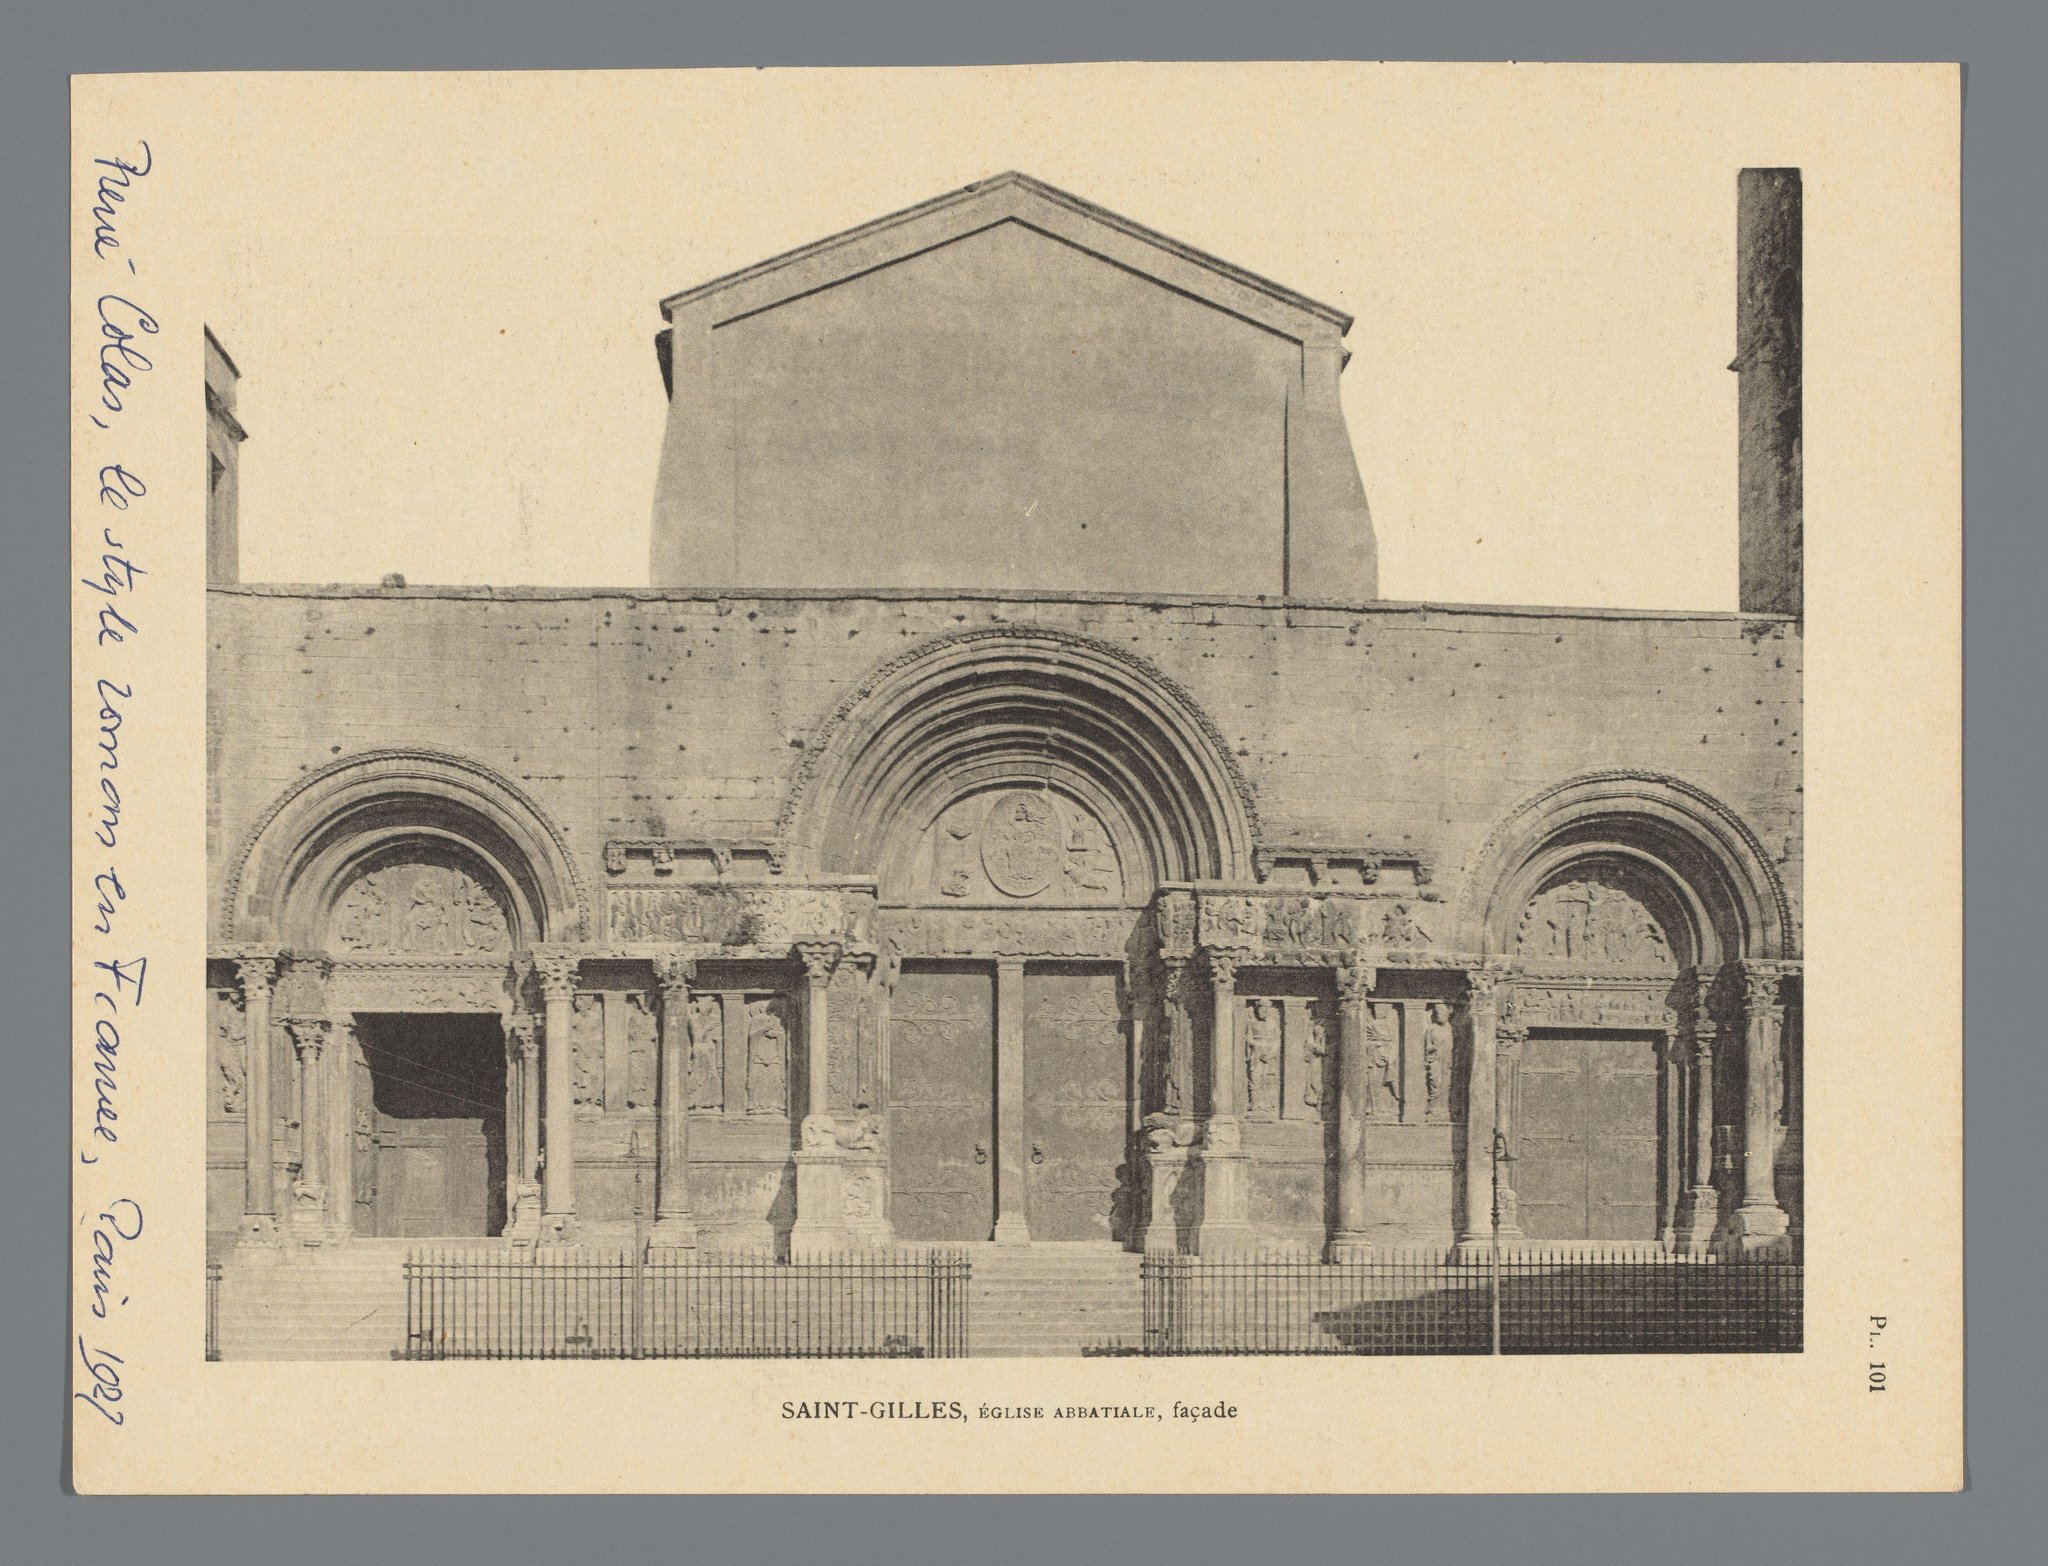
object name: photograph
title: Saint-Gilles, Kirche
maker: Anonymous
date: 1900-1950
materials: paper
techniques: rotogravure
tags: france